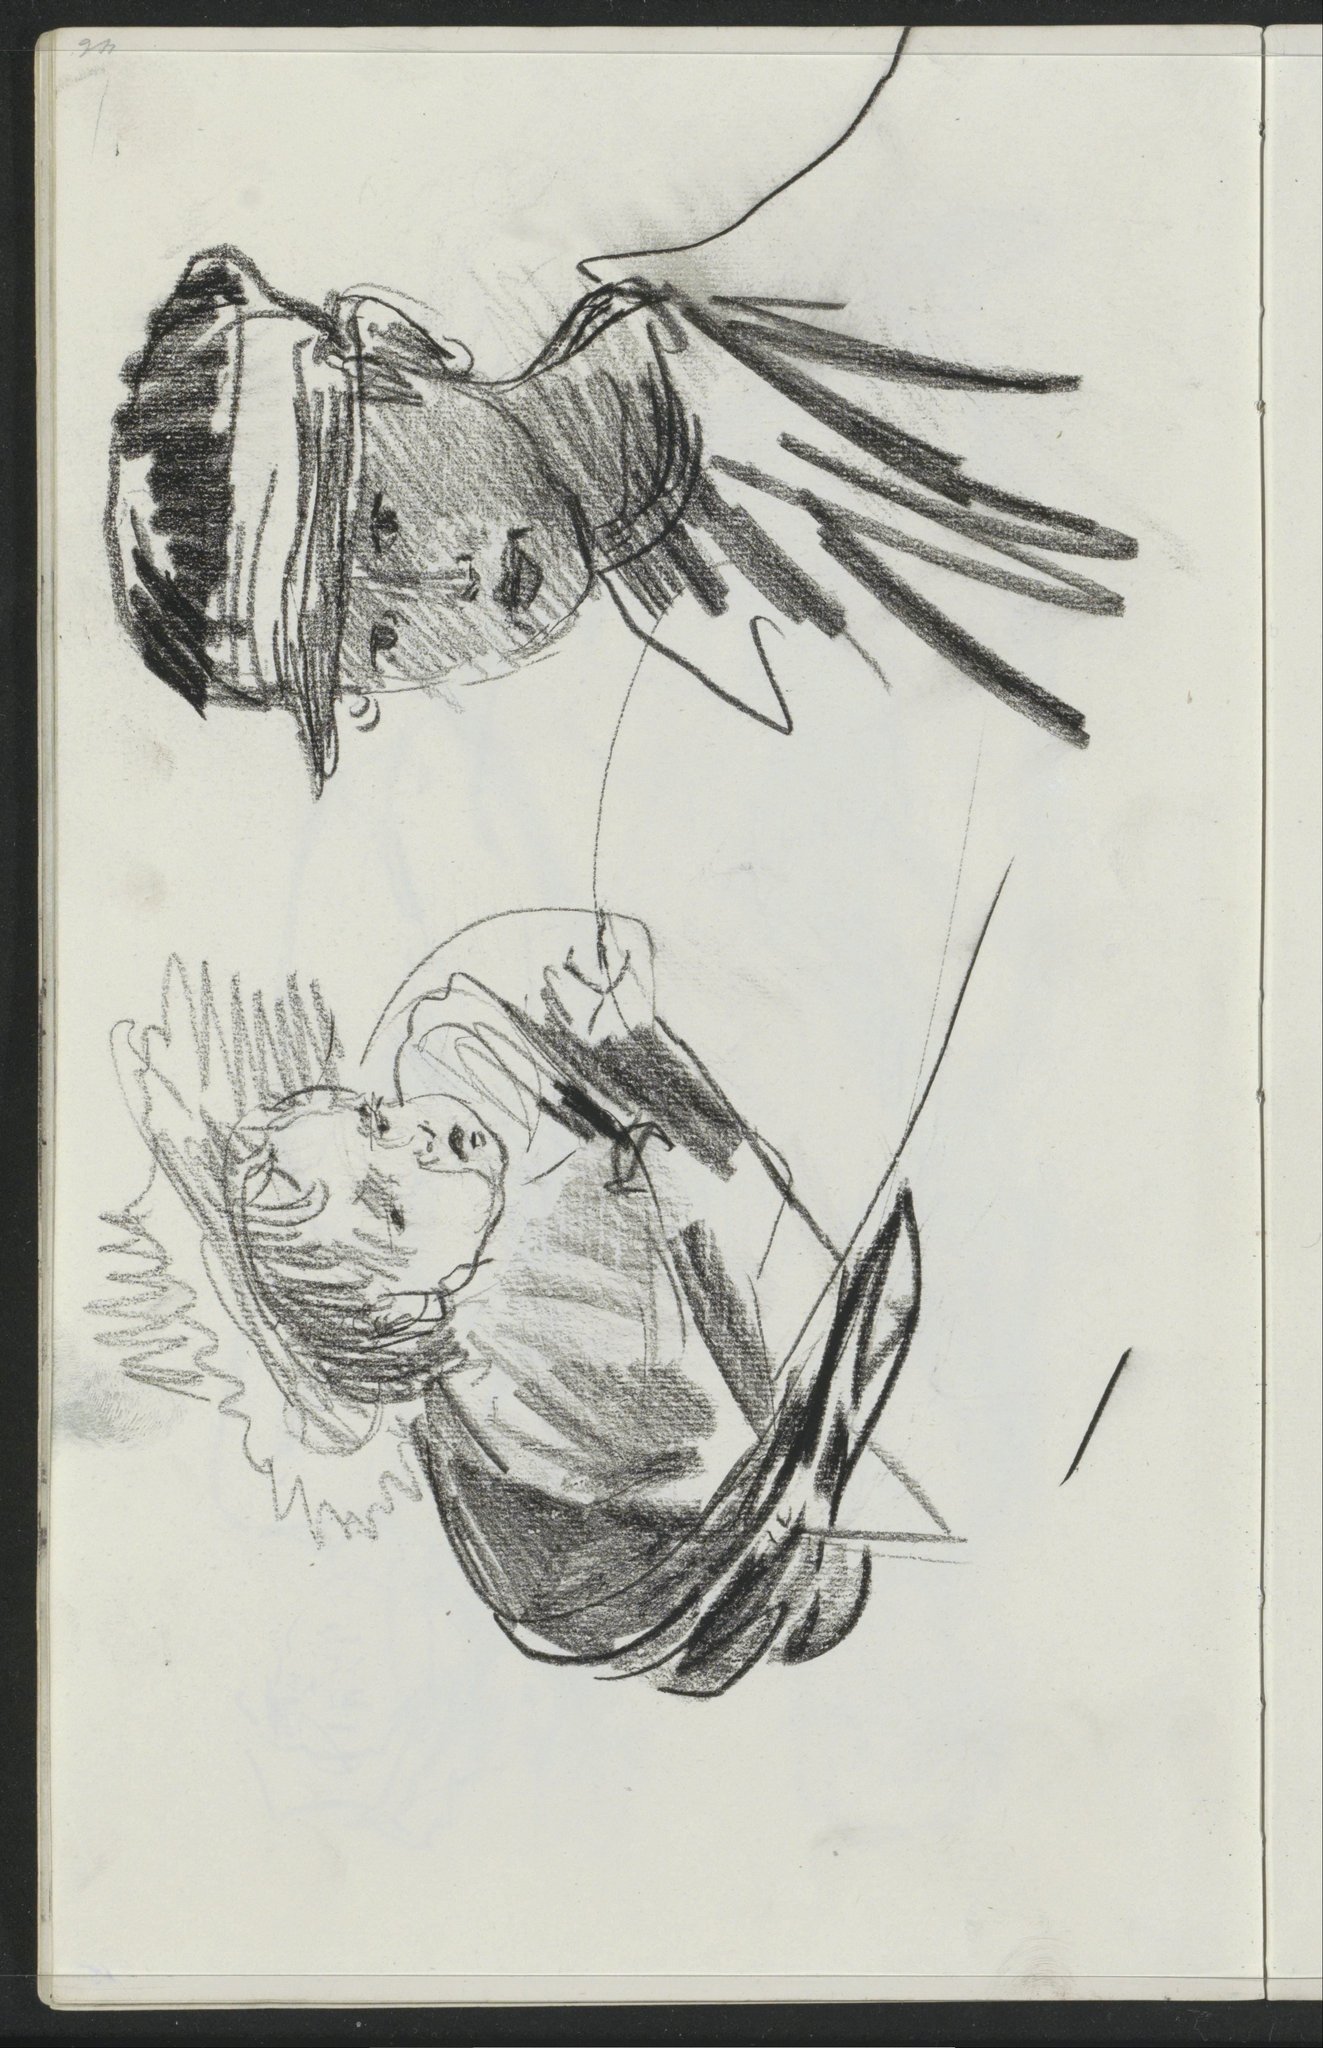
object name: sketchbook leaf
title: Baby in een kinderwagen en een jongenshoofd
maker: isaac israels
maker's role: draughtsman, painter, print maker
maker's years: 1865-1934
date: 1875-1934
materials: chalk, paper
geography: amsterdam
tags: baby-carriage, pram, perambulator, boy (child between toddler and youth)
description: Blad 15 verso uit schetsboek XI met 30 bladen.